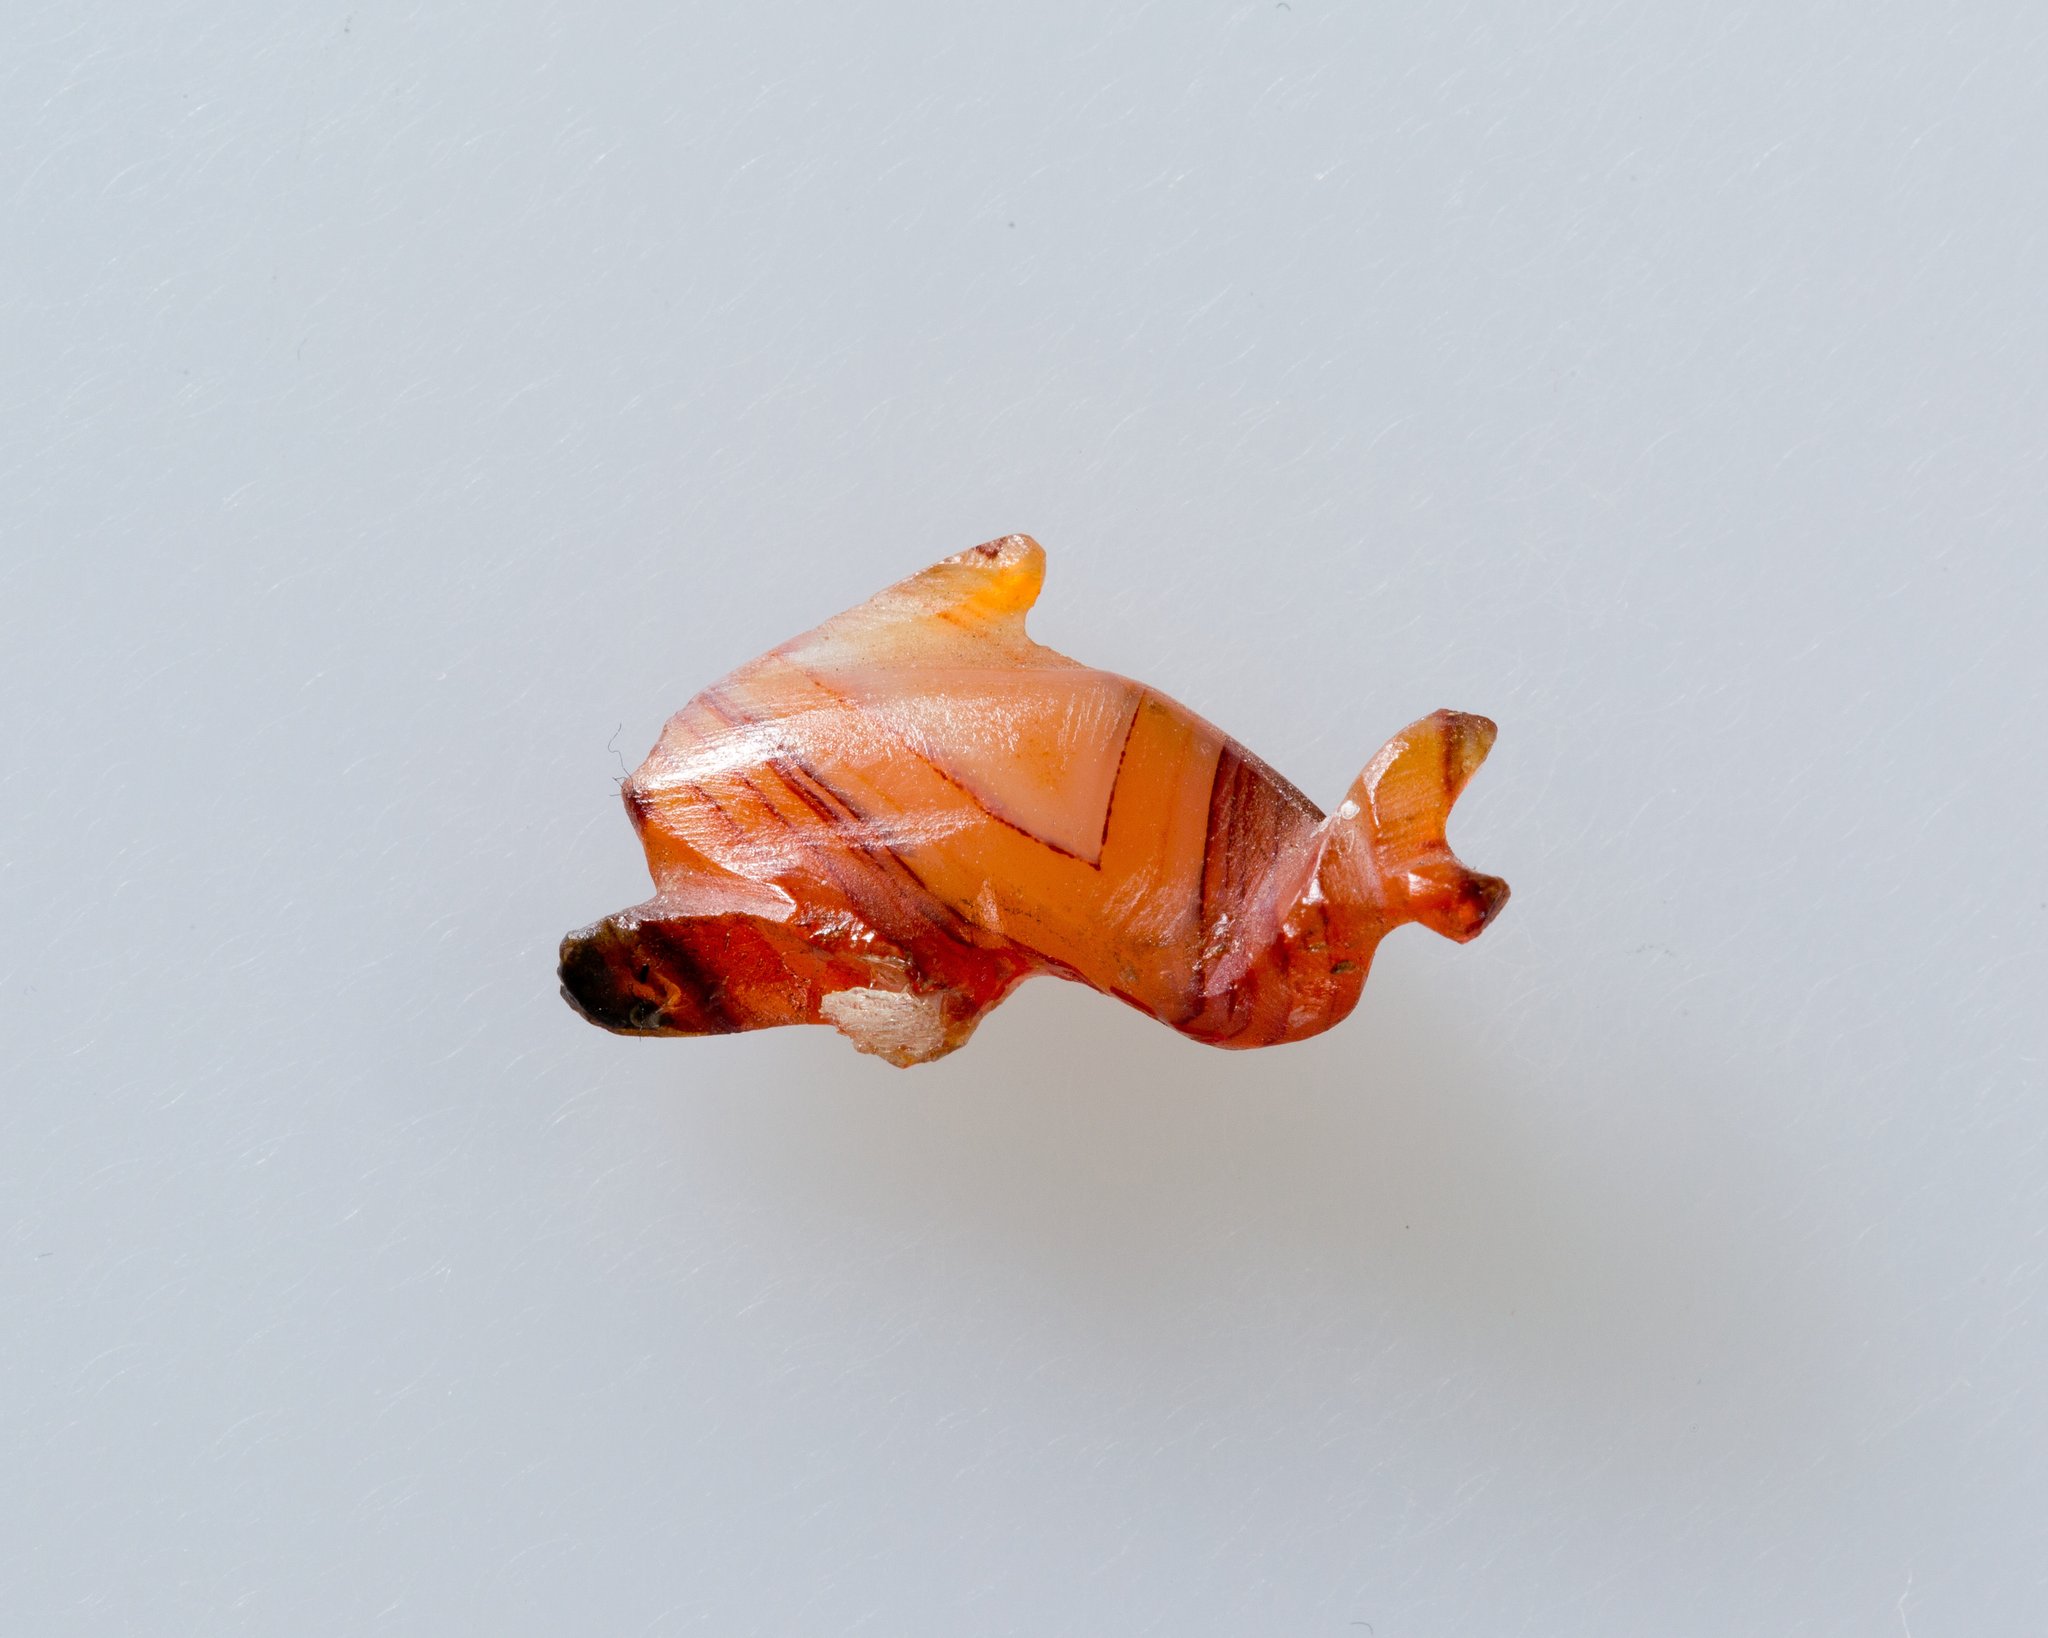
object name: amulet, fish dolphin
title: Dolphin amulet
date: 200 BCE-200 CE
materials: stone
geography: egypt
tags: dolphins